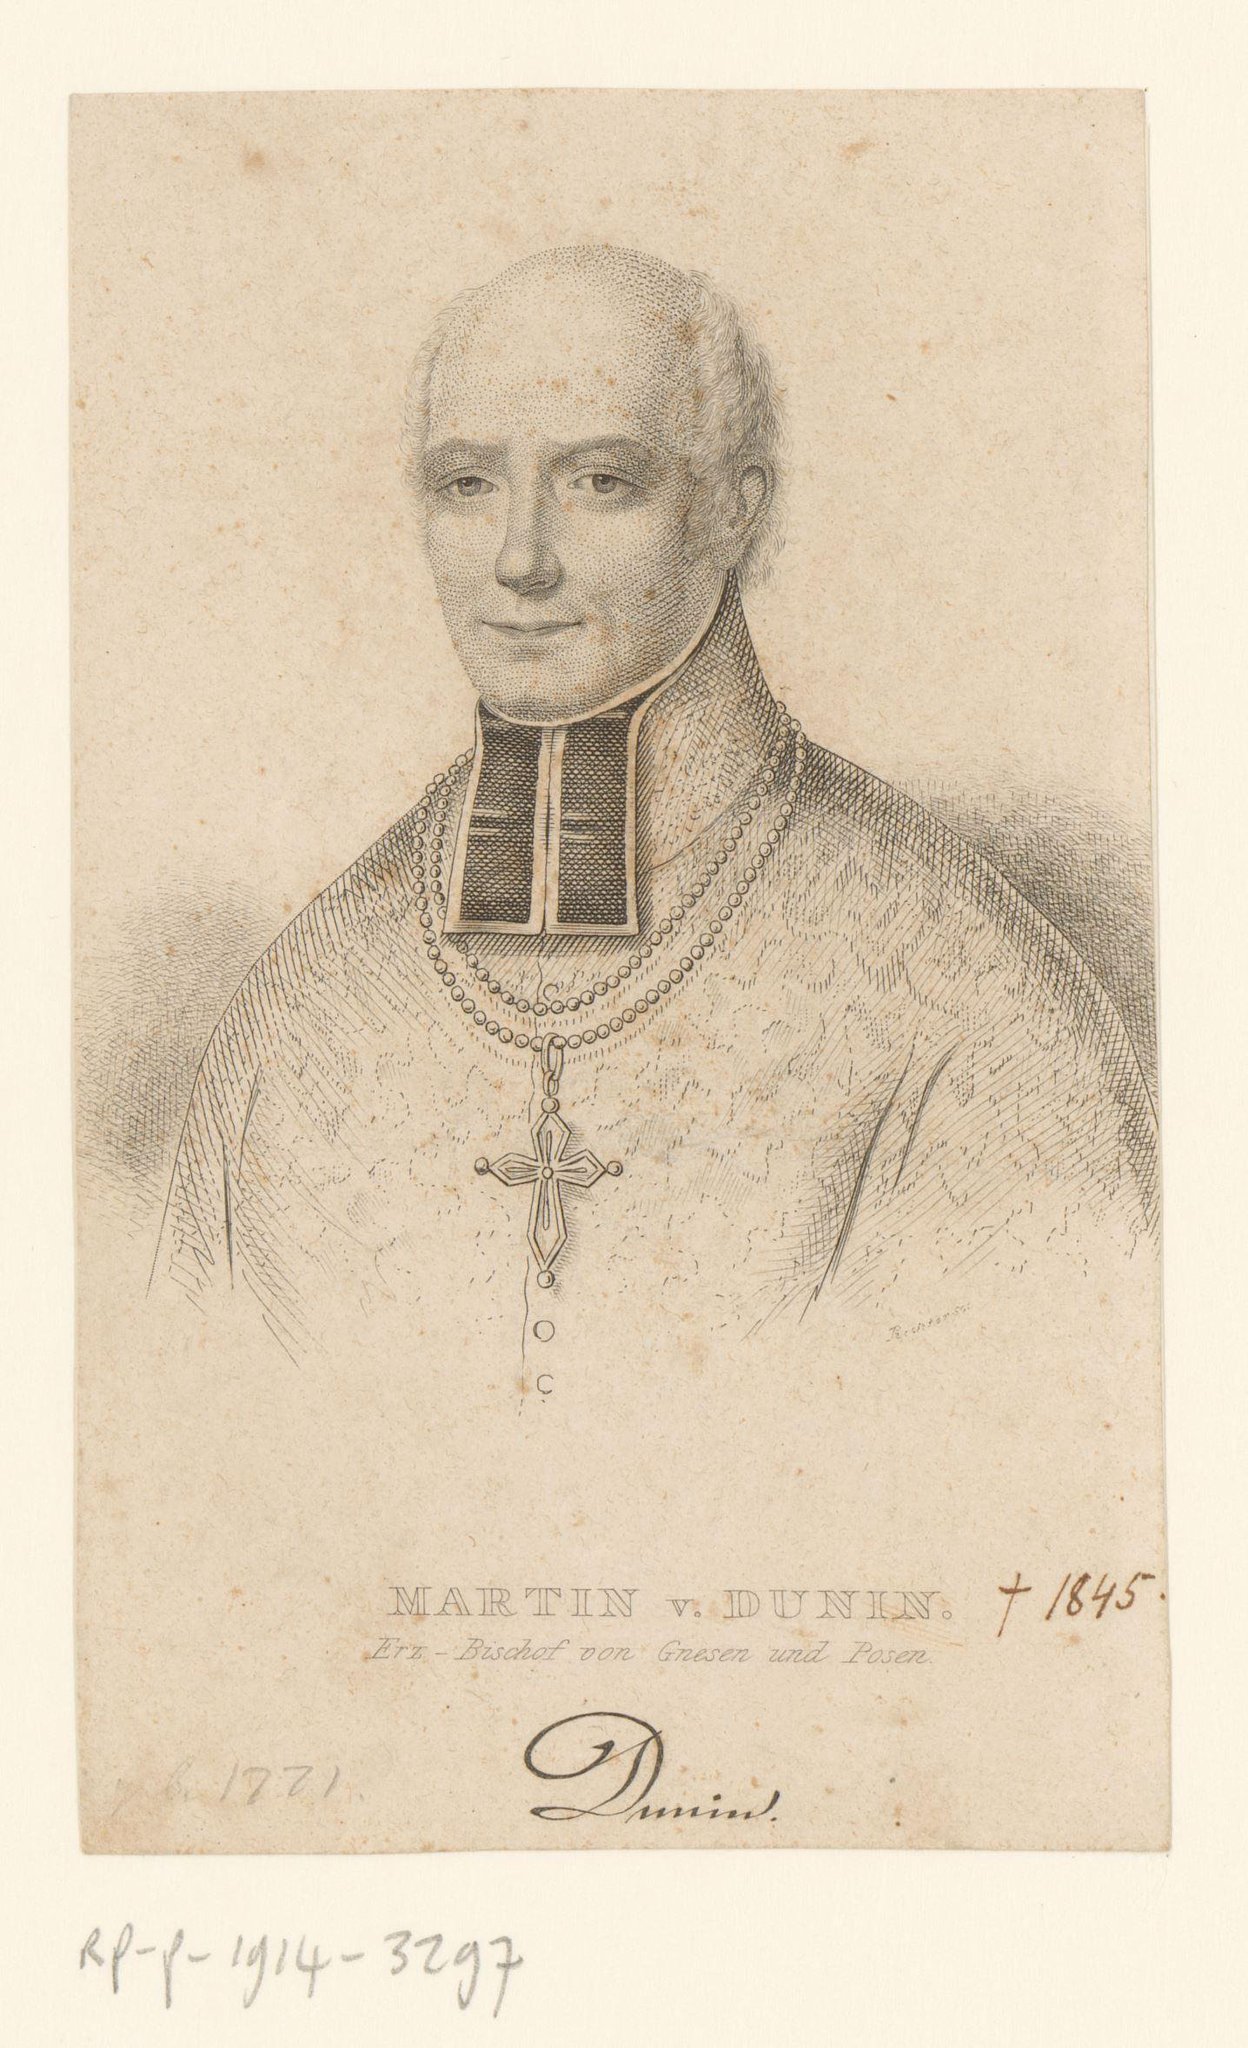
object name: print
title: Portret van Martin von Dunin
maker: f. richter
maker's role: print maker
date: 1800-1899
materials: paper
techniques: engraving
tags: theologian, historical persons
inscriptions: collector's mark: Lugt 2228